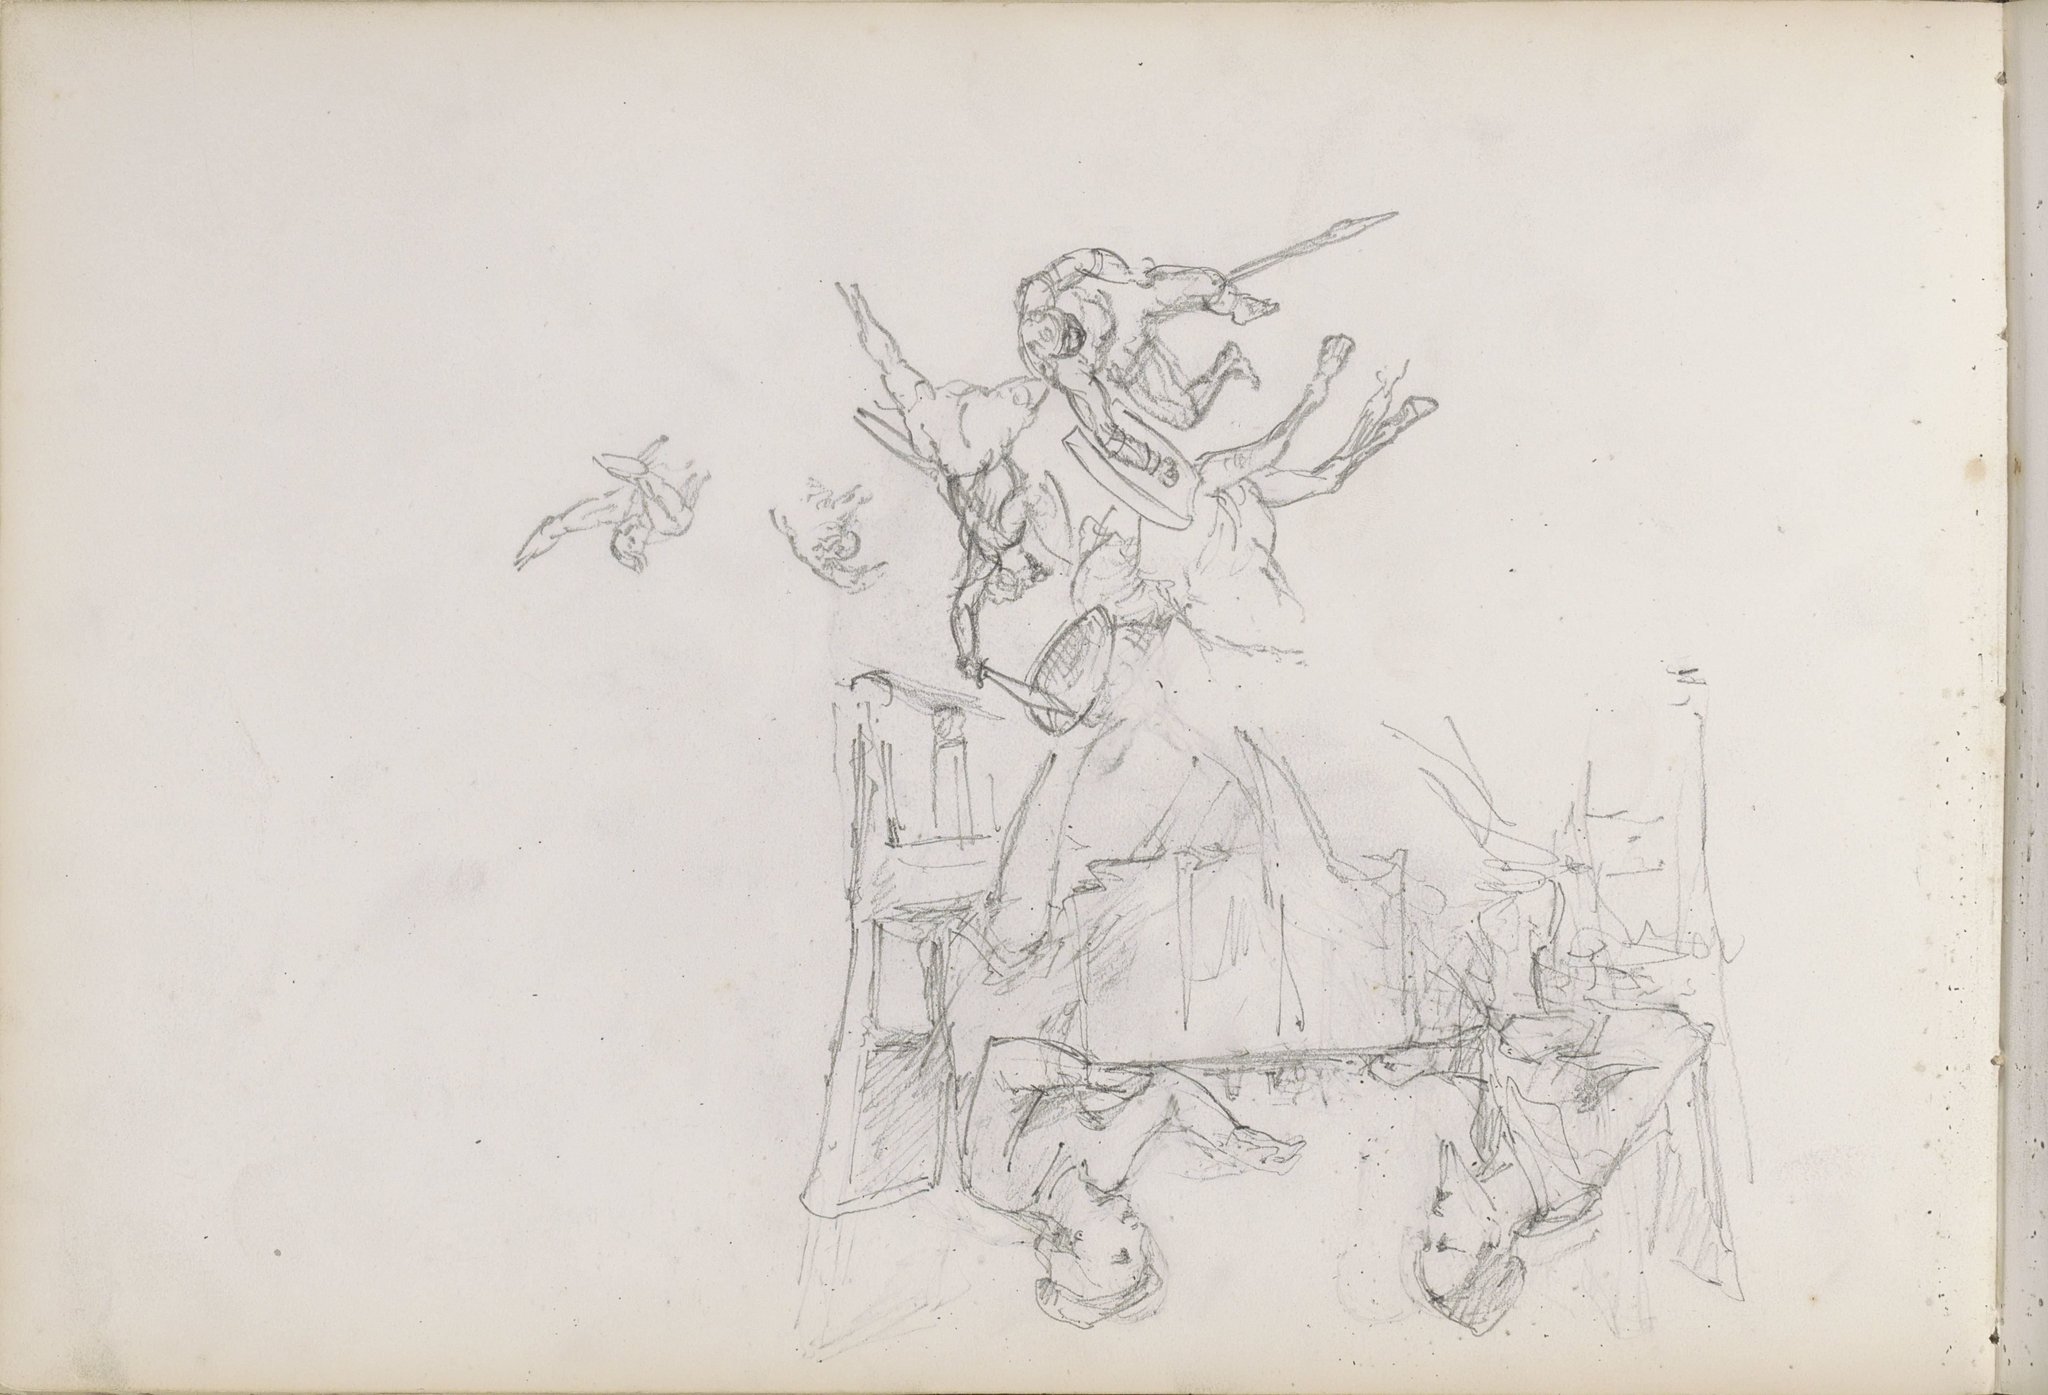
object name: sketchbook leaf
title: Strijdende soldaten en twee figuren aan een tafel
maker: george hendrik breitner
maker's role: draughtsman, painter, print maker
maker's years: 1857-1923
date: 1873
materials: paper, pencil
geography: rotterdam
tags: division of armed forces (+ during the battle), table, horse, sitting on an elevation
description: Blad 44 verso uit een schetsboek met 25 bladen.